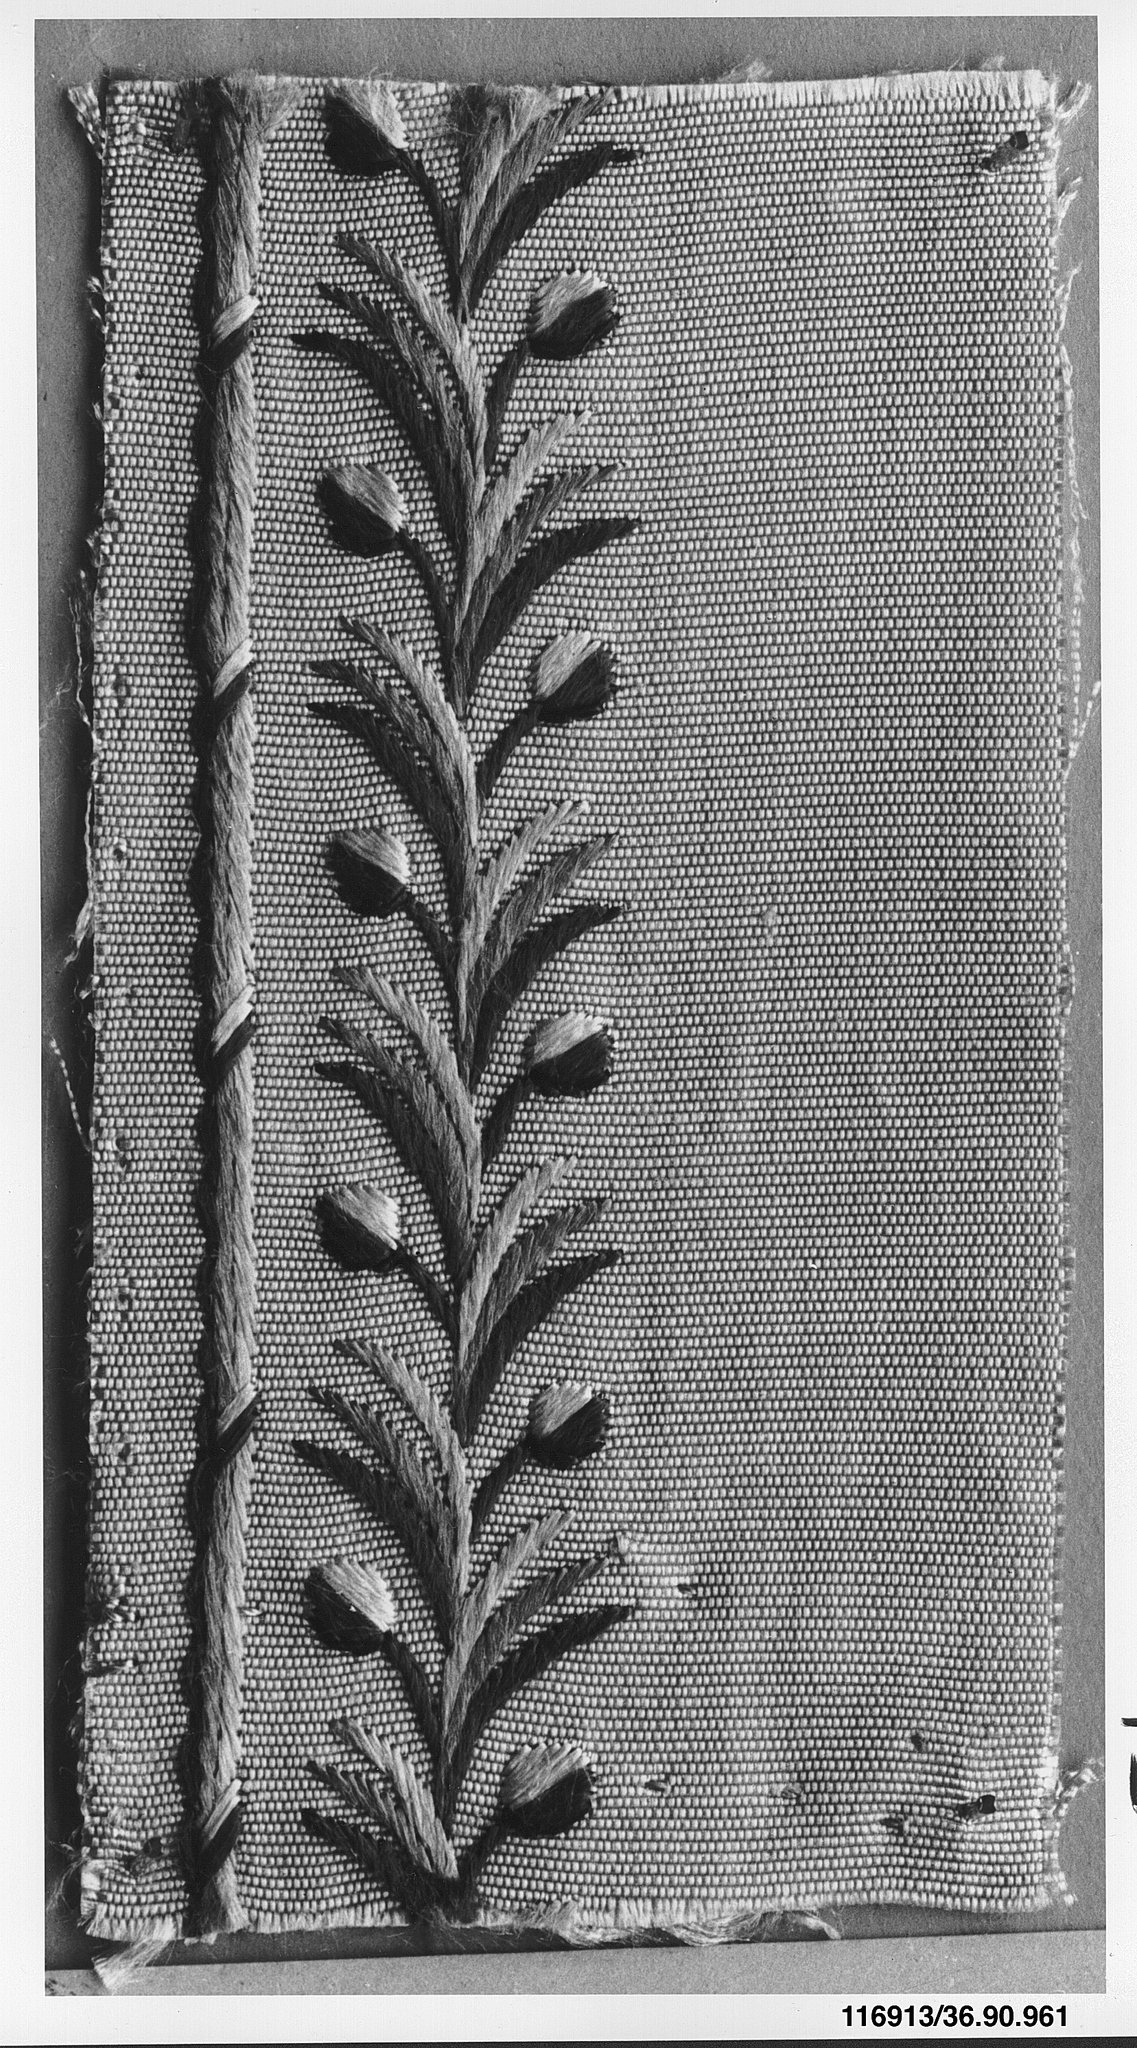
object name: sample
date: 1801-1833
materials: silk